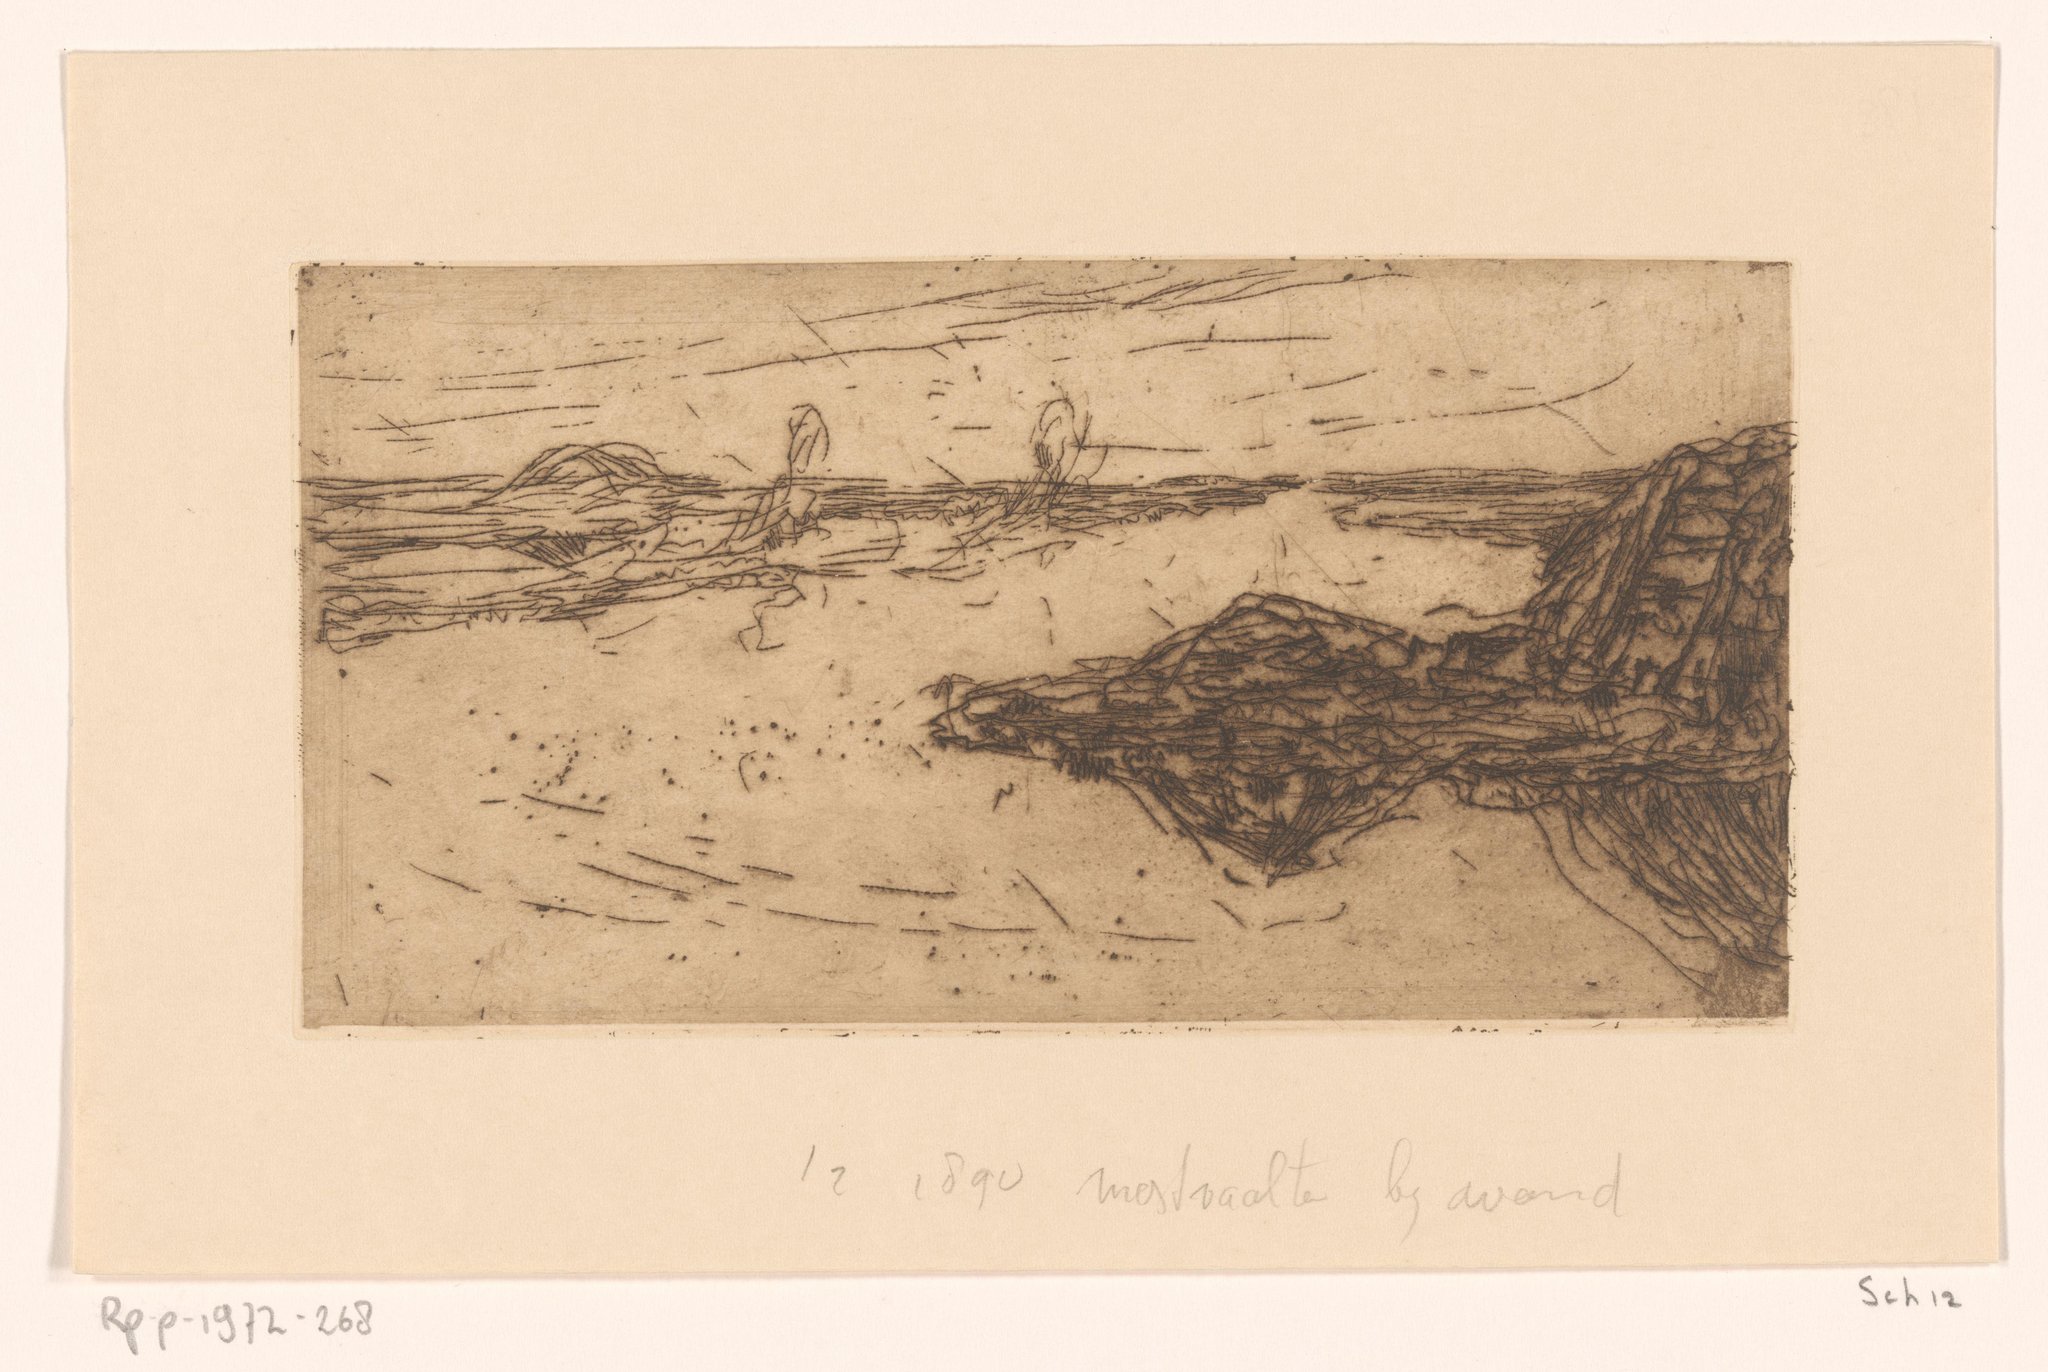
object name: print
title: Landschap met water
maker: floris verster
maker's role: draughtsman, painter, print maker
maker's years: 1861-1927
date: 1890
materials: paper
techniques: drypoint, etching, intaglio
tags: landscapes in the temperate zone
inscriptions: collector's mark: Lugt 2760, collector's mark: Lugt 2228